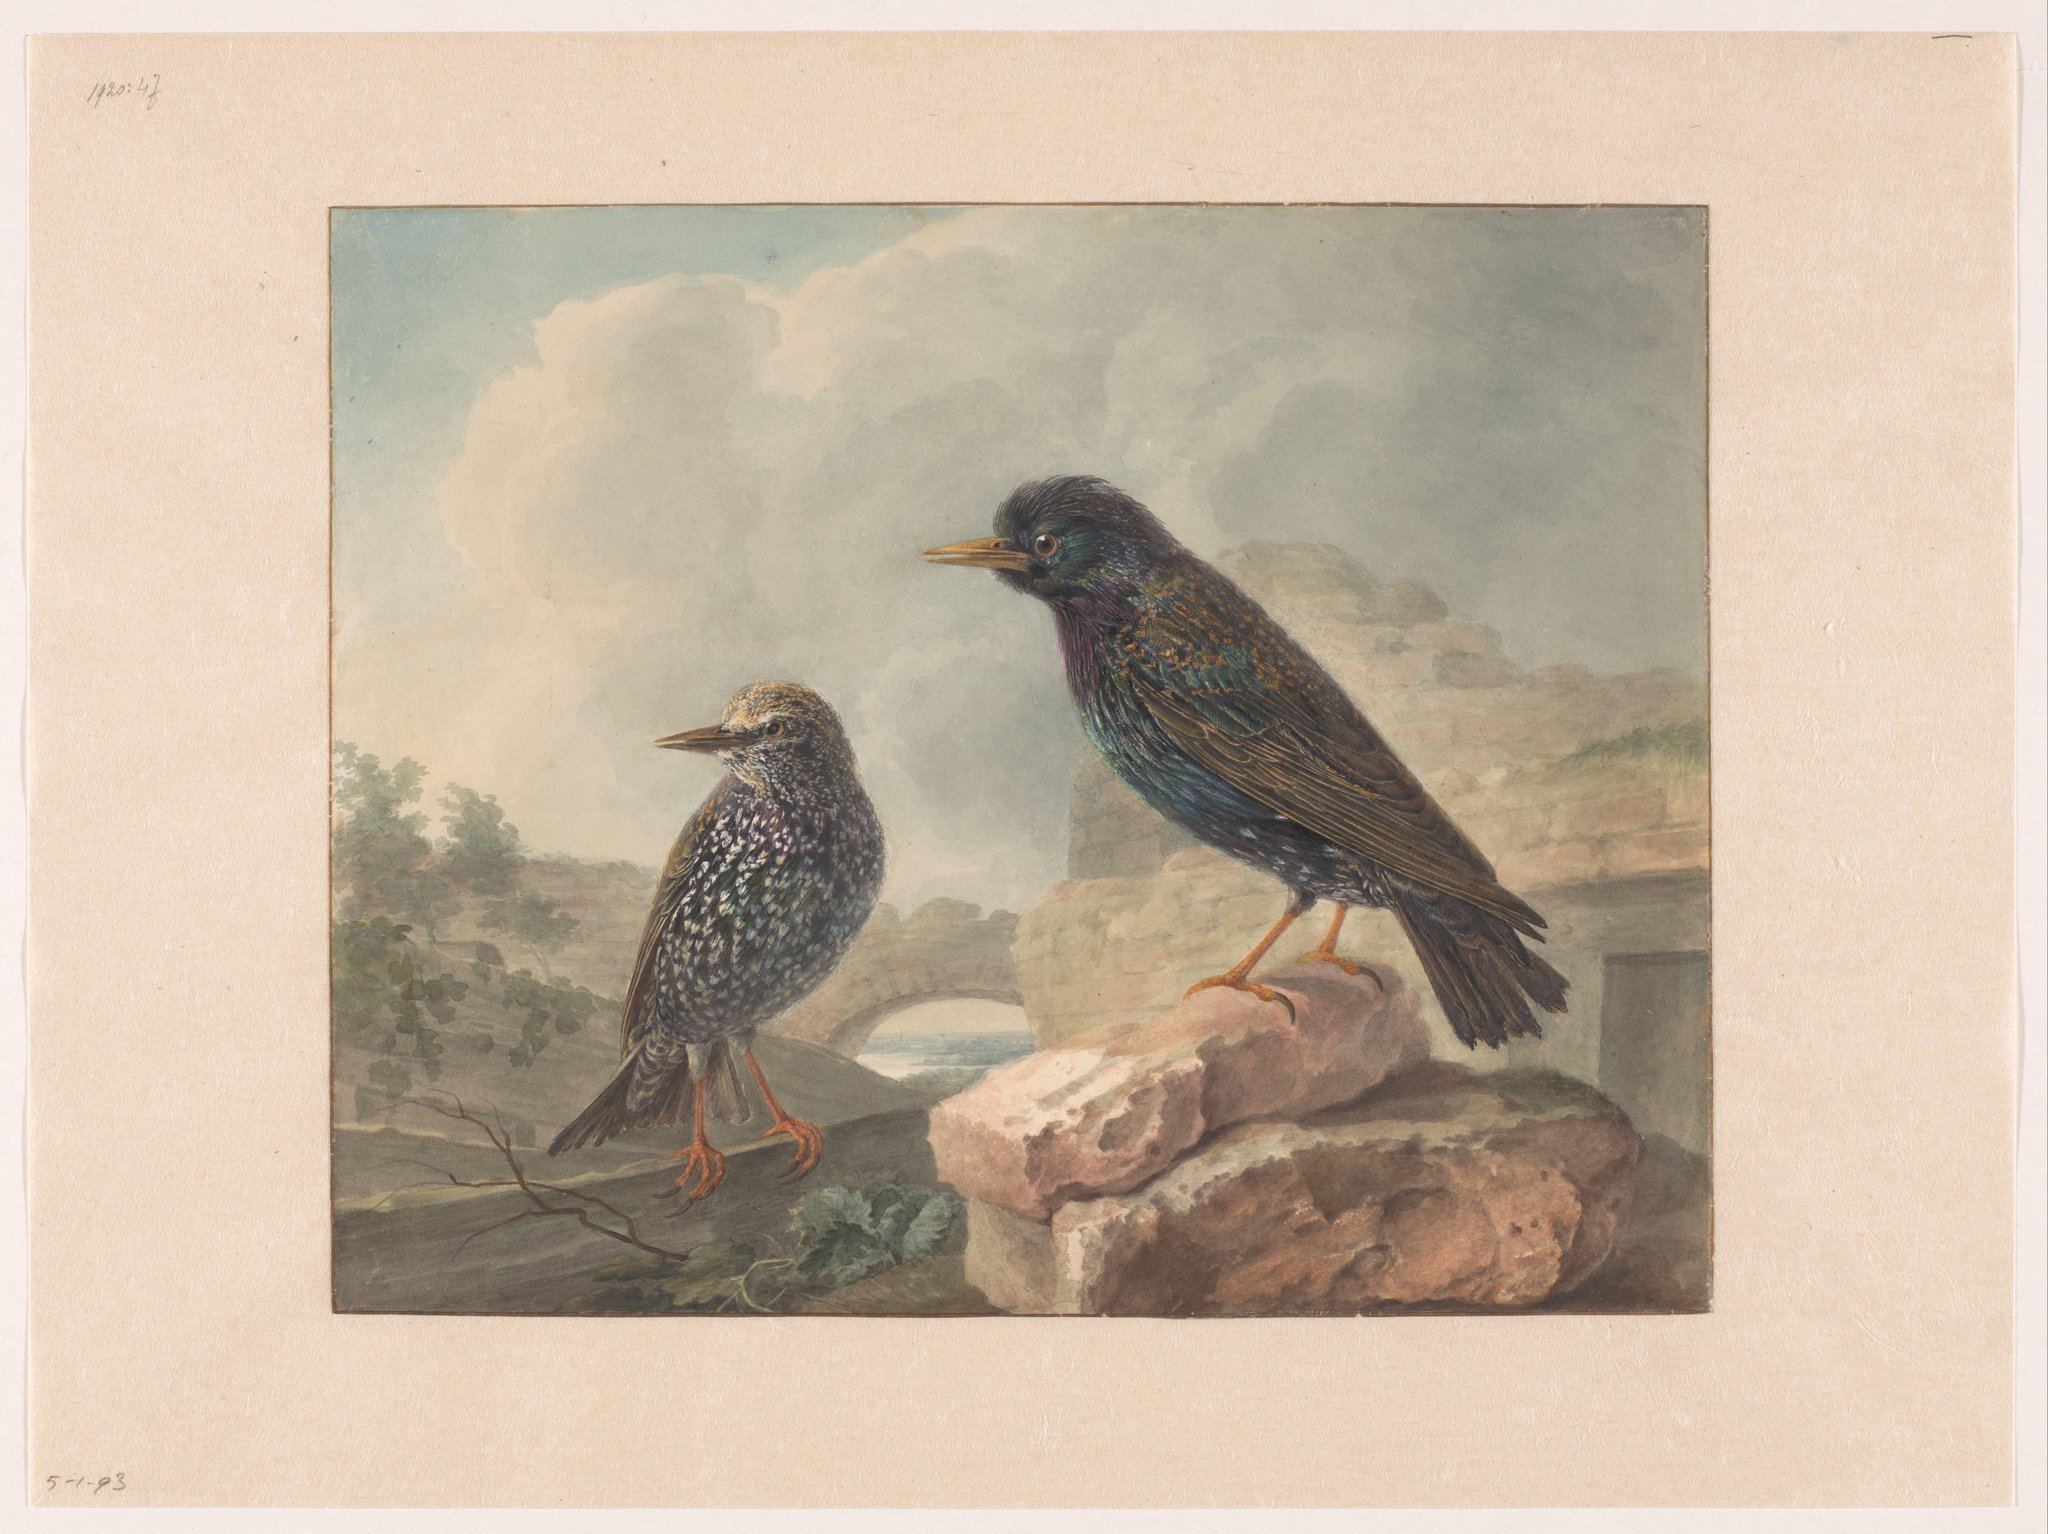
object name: watercolor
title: Twee spreeuwen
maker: cornelis van hardenbergh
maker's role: draughtsman, painter, print maker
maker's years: 1755-1843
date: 1765-1873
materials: paint, paper, watercolor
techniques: brush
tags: song-birds: starling